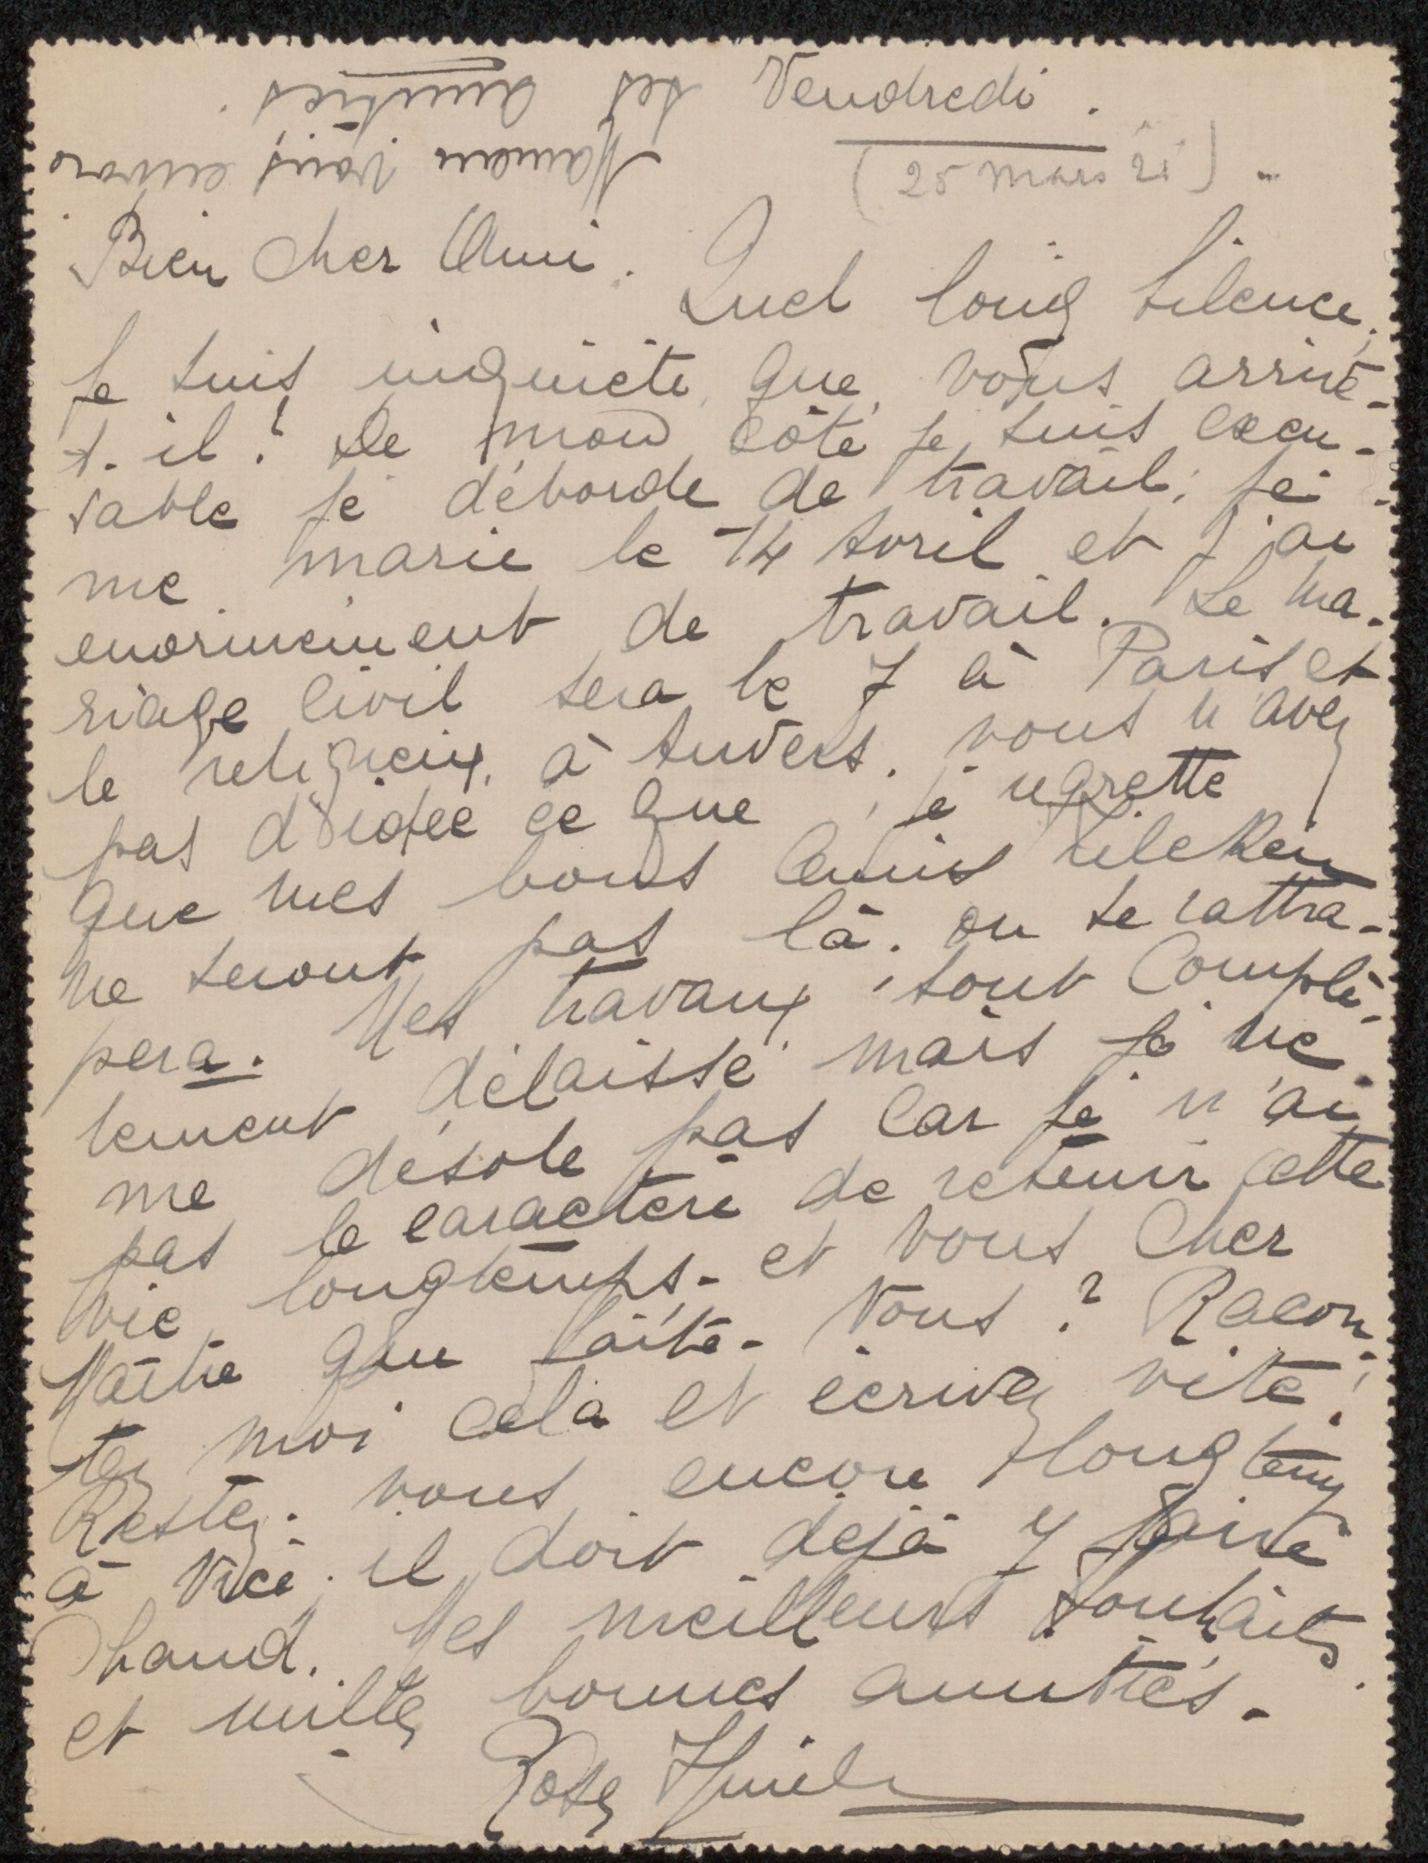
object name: letter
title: Brief aan Philip Zilcken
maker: rose imel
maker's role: draughtsman, painter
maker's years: 1901-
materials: ink, paper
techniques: pen, writing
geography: paris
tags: painter, draughtsman, philip zilcken, family life, antwerp, paris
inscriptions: collector's mark: ‘RPK’